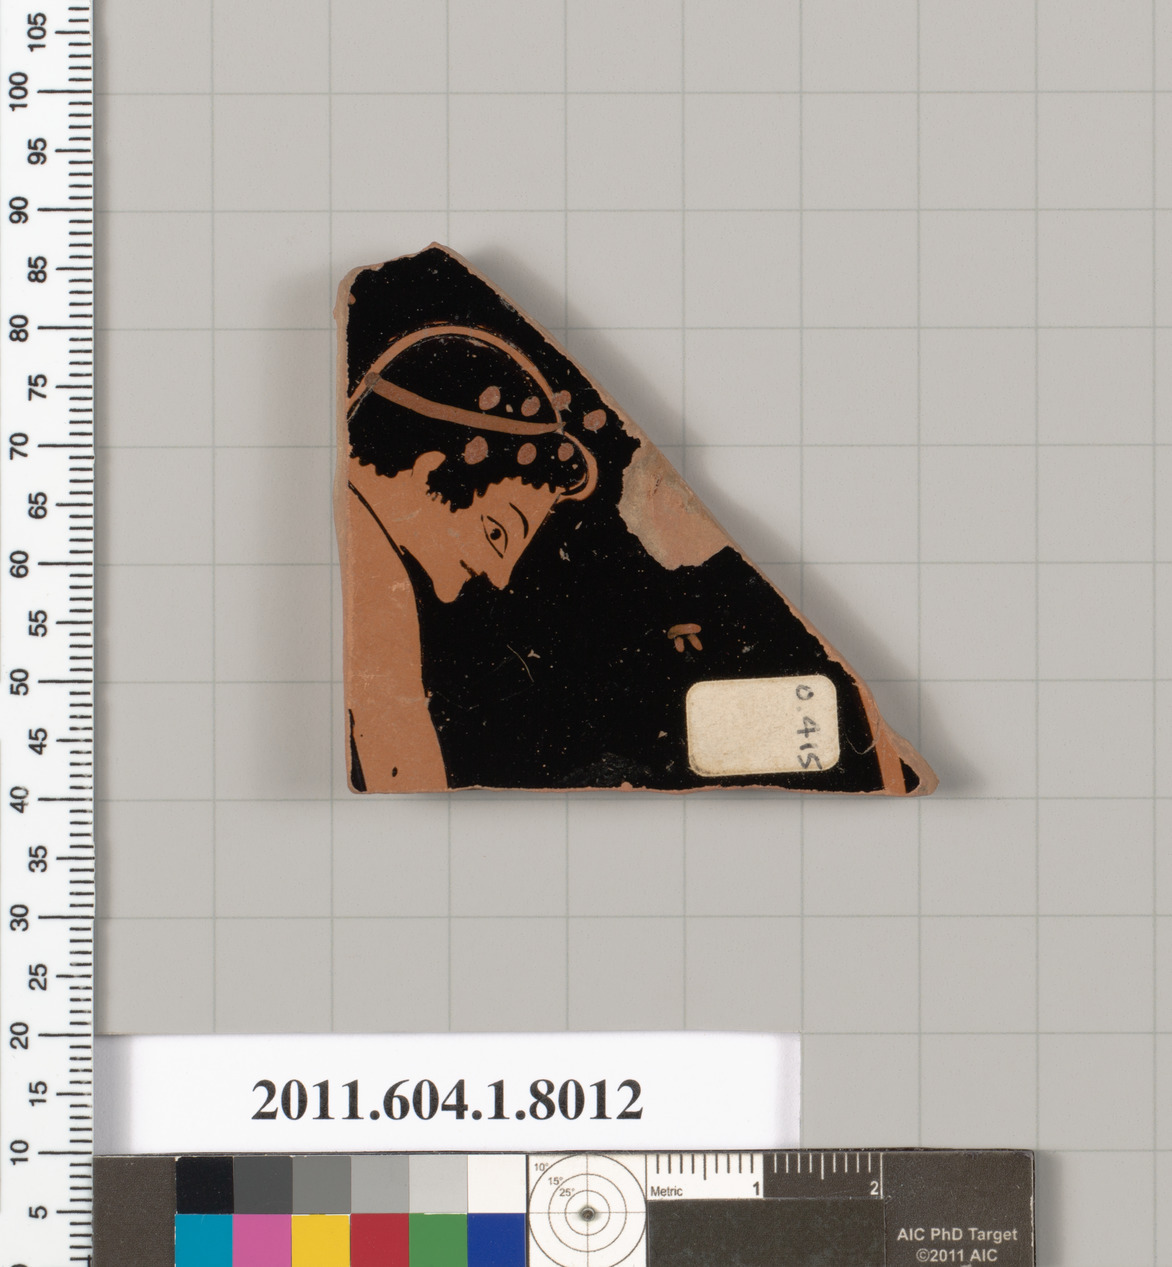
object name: kylix fragment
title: Terracotta fragment of a kylix (drinking cup)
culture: greek, attic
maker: euergides painter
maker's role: artist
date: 510-500 BCE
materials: terracotta